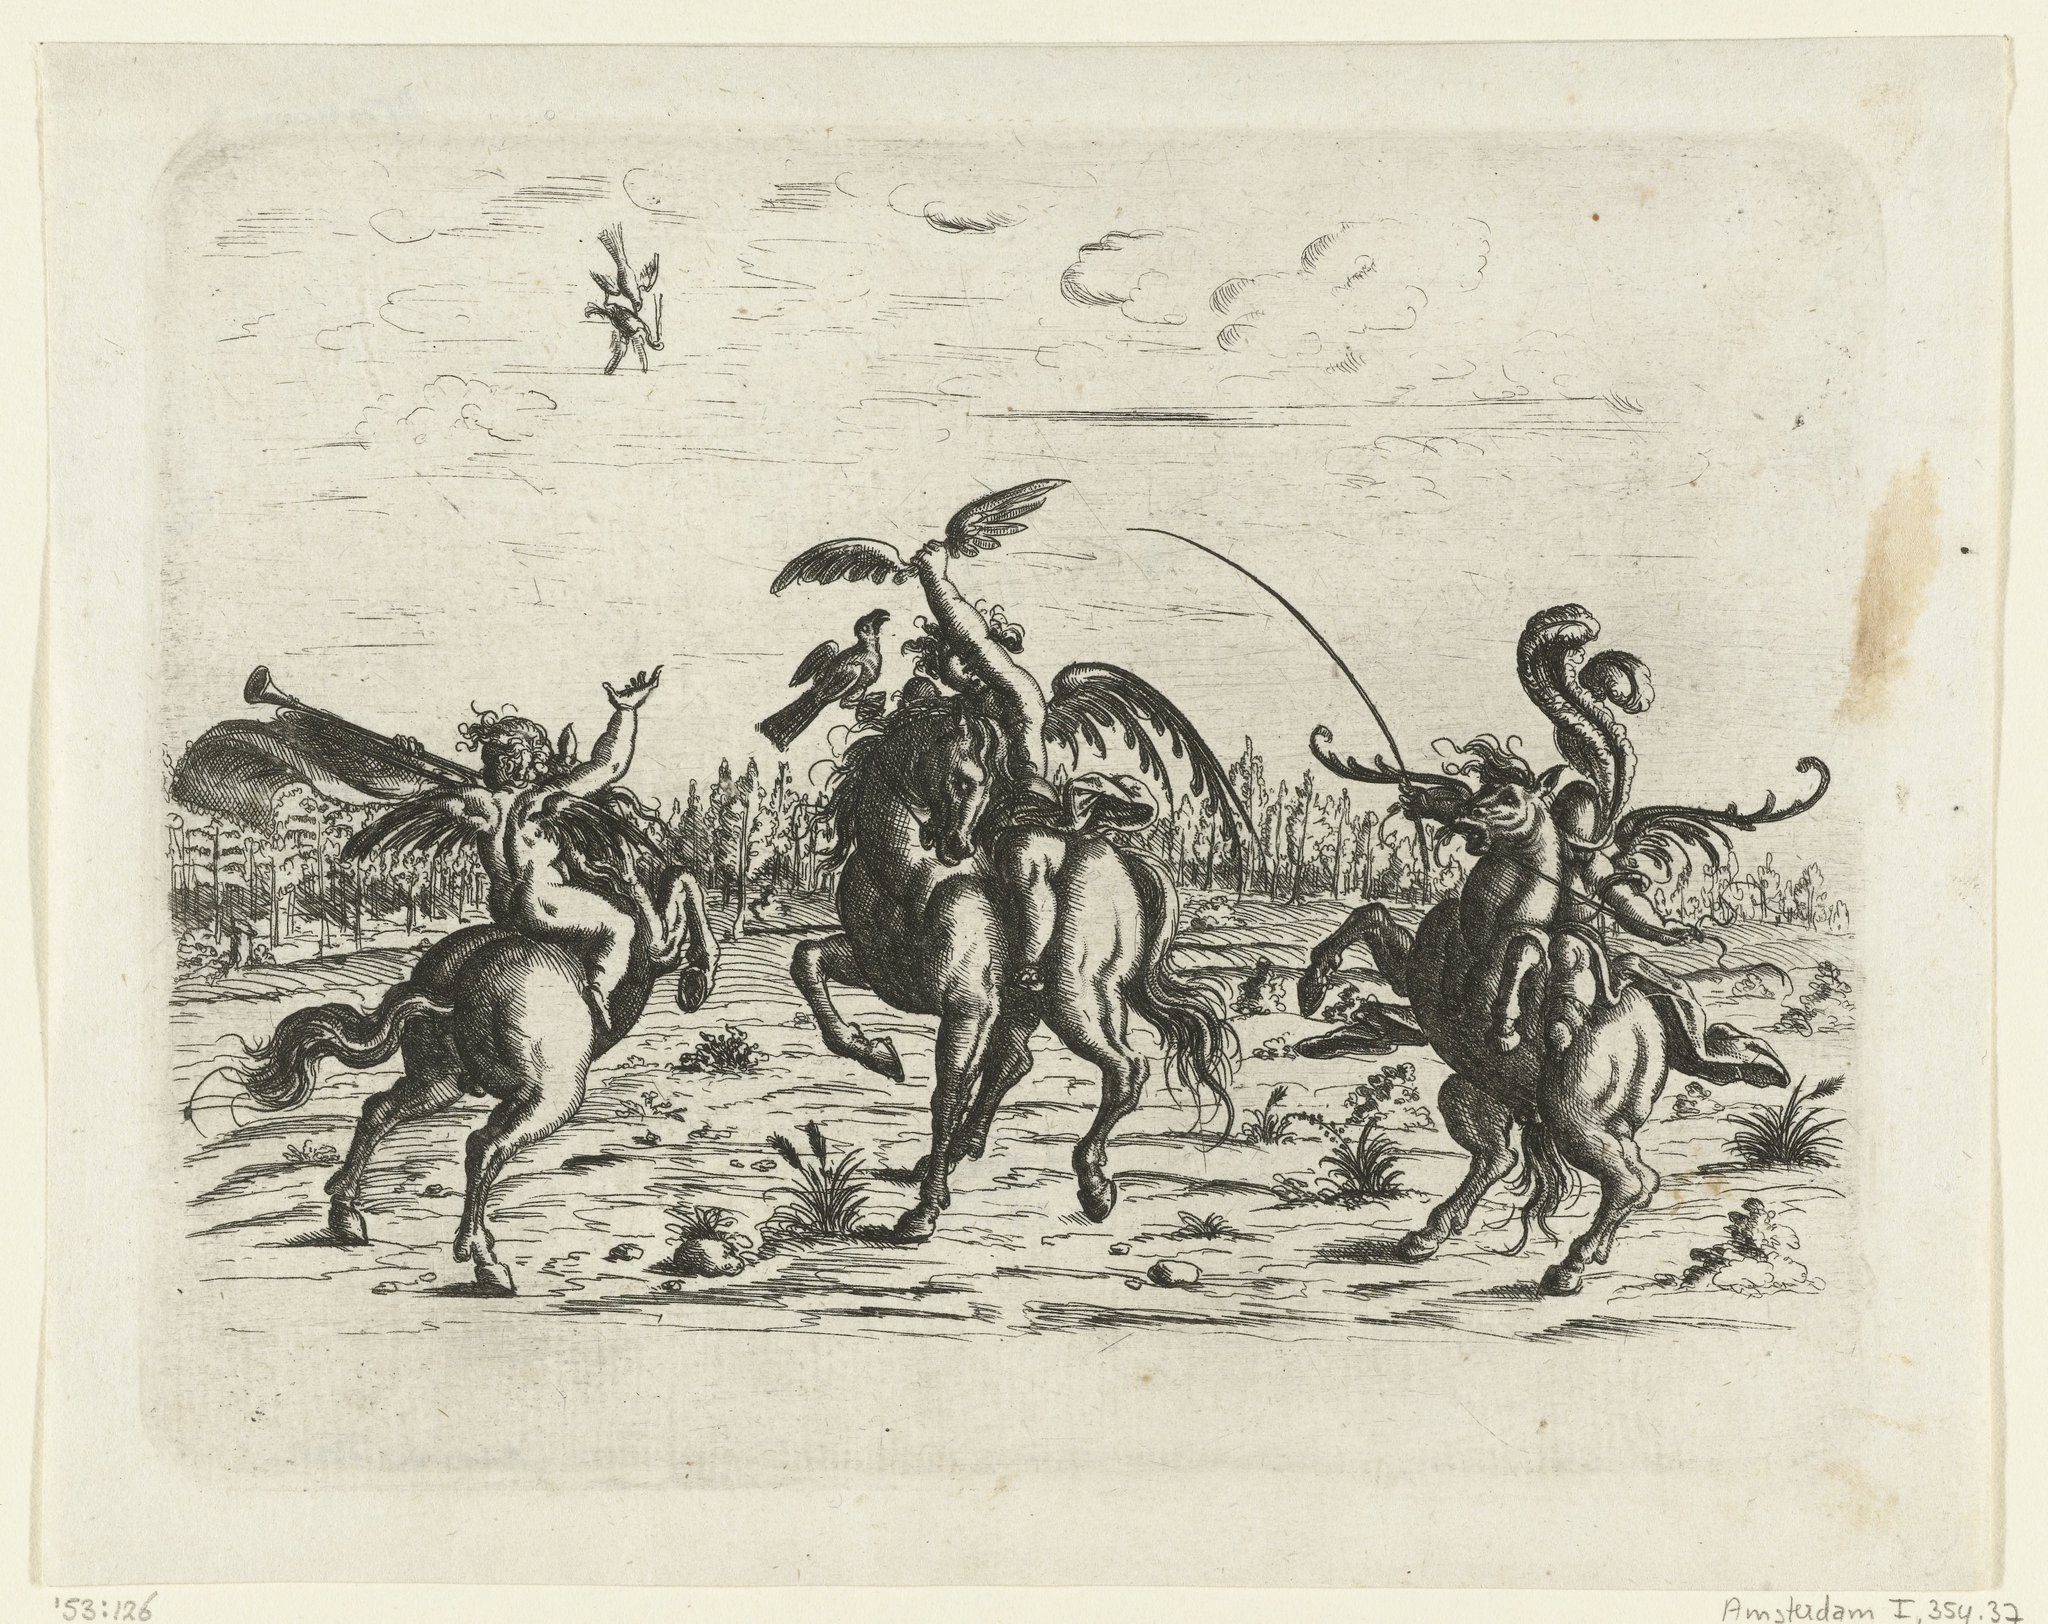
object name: print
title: Landschap met drie putti te paard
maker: christoph jamnitzer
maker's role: draughtsman, goldsmith, print maker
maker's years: 1563-1618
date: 1573-1610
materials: paper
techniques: etching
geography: germany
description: De putto links blaast op een bazuin. Blad uit een serie vlakdecoraties met grotesken, cartouches, ovalen, mascarons, putti en fantastische wezens. De serie bestaat uit drie titelbladen, twee tekstbladen met de opdracht en het voorwoord en 60 bladen, verdeeld over drie boeken.